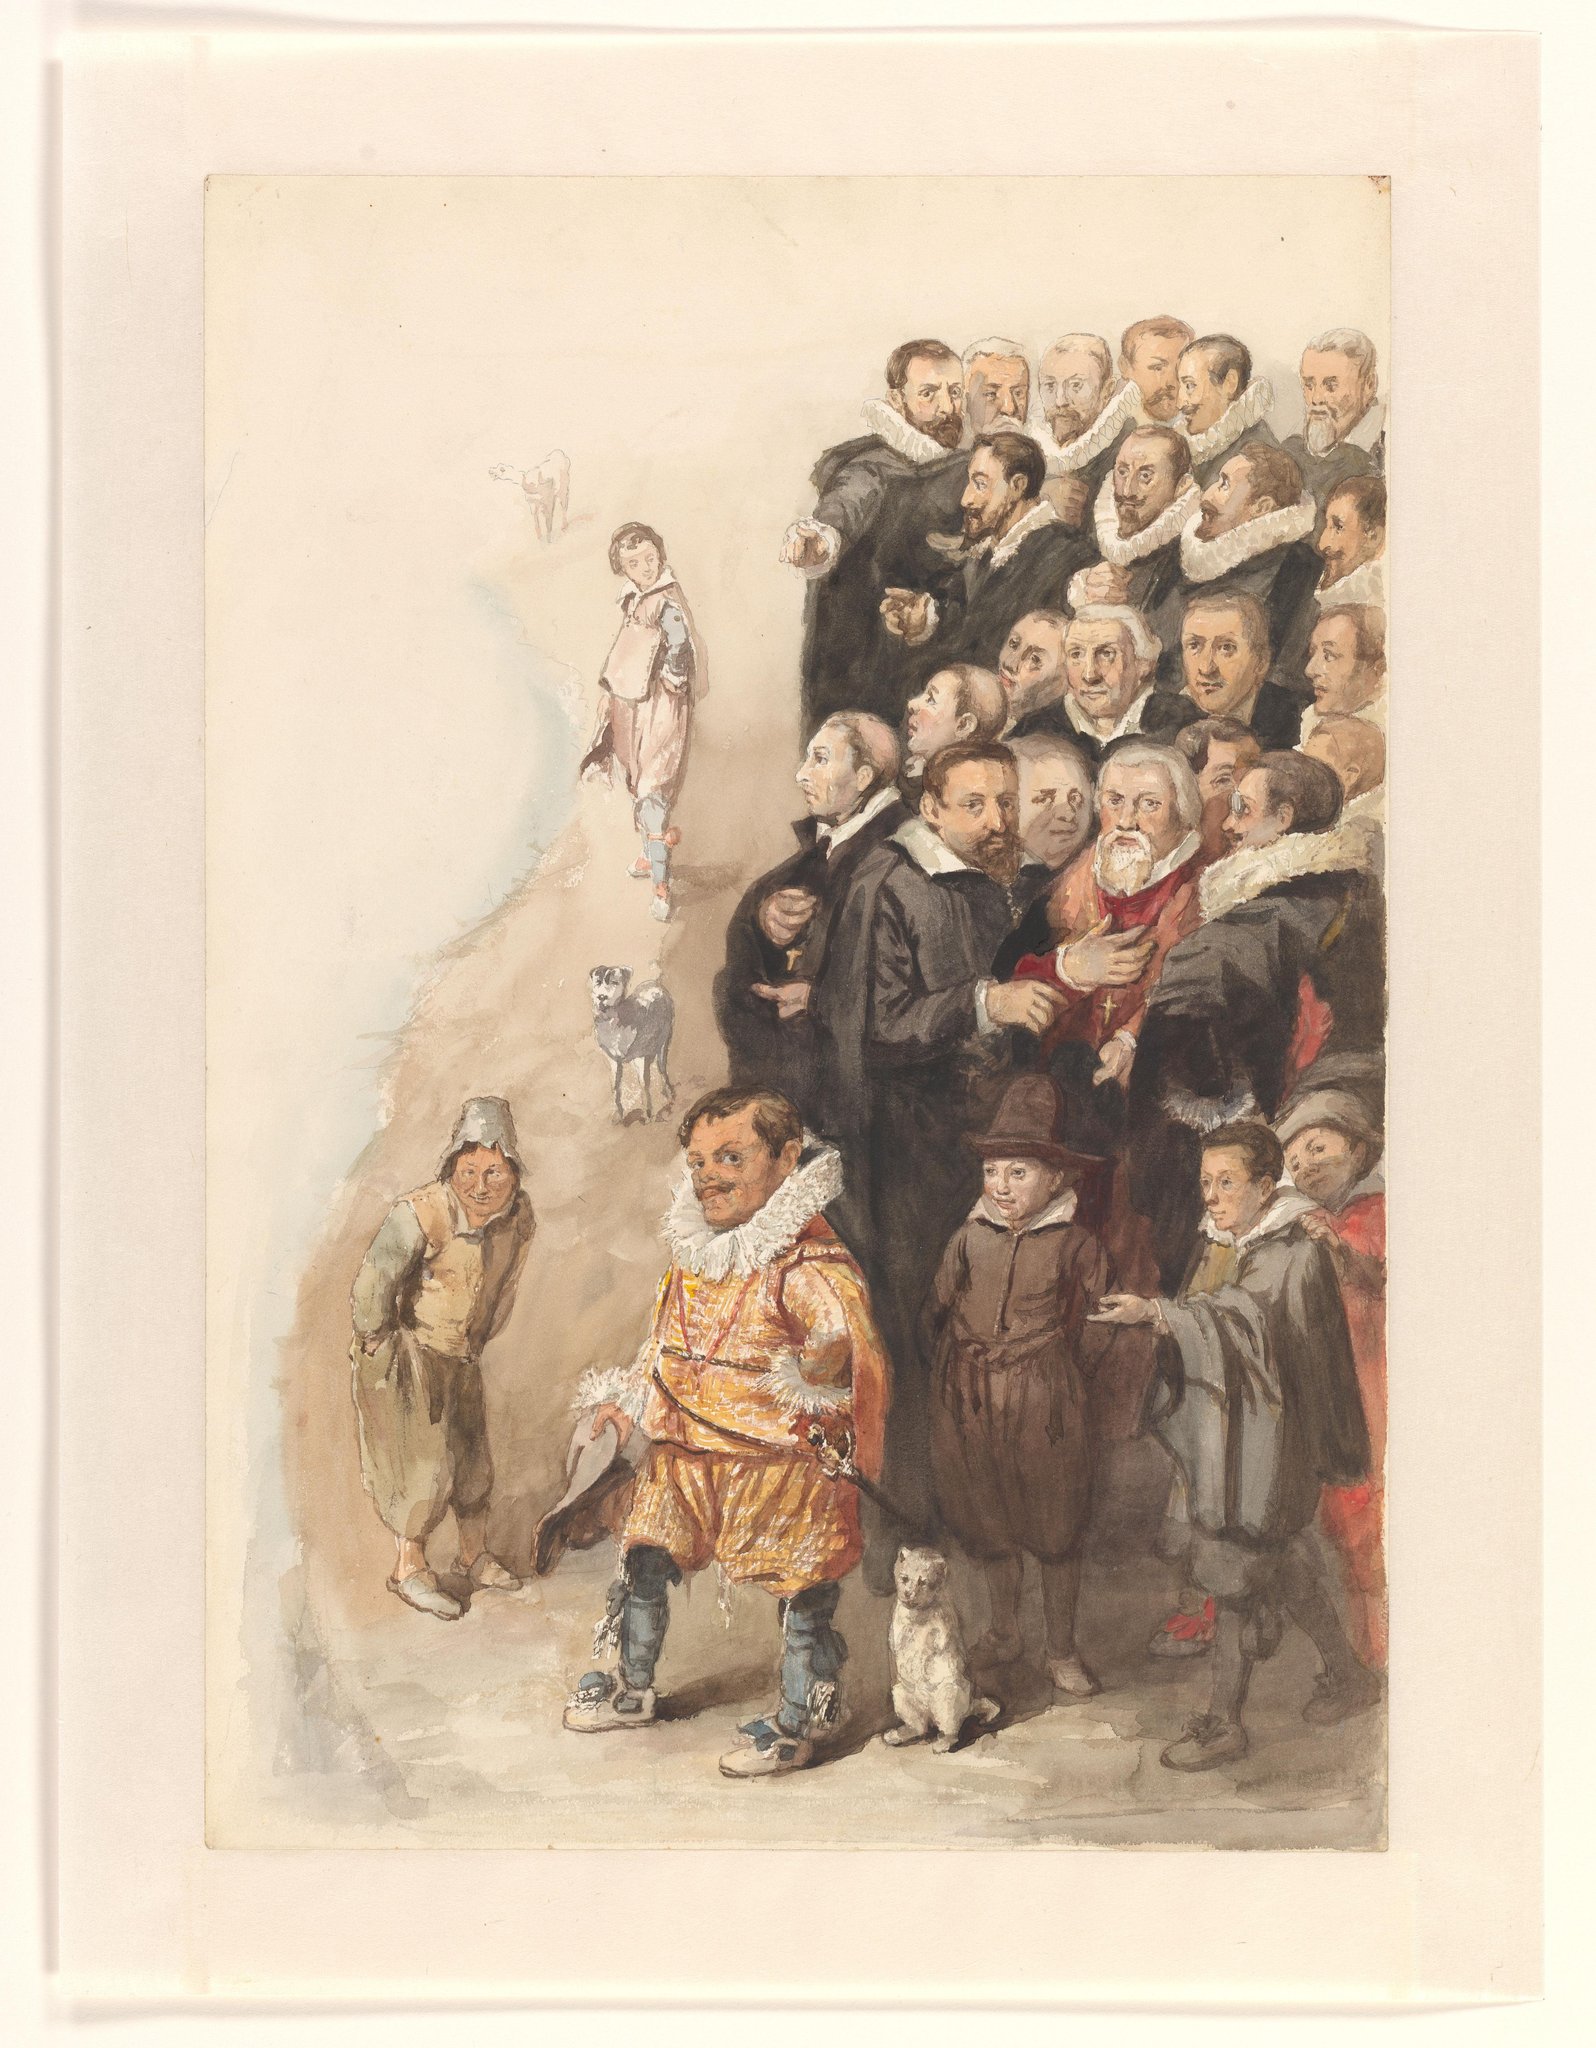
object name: drawing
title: Rechteroever met katholieke personen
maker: jacob taanman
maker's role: draughtsman, print maker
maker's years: 1836-1923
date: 1846-1923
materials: ink, paper, watercolor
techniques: brush, pen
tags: river (+ landscape with figures, staffage), the roman catholic church vs. protestantism; (reformation and counter reformation)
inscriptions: collector's mark: Lugt 964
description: Rechteroever van een rivier met katholieke aartshertogen, kardinalen en hun aanhangers. Detail naar het schilderij 'De Zielenvisserij' van Adriaen Pietersz. van de Venne.